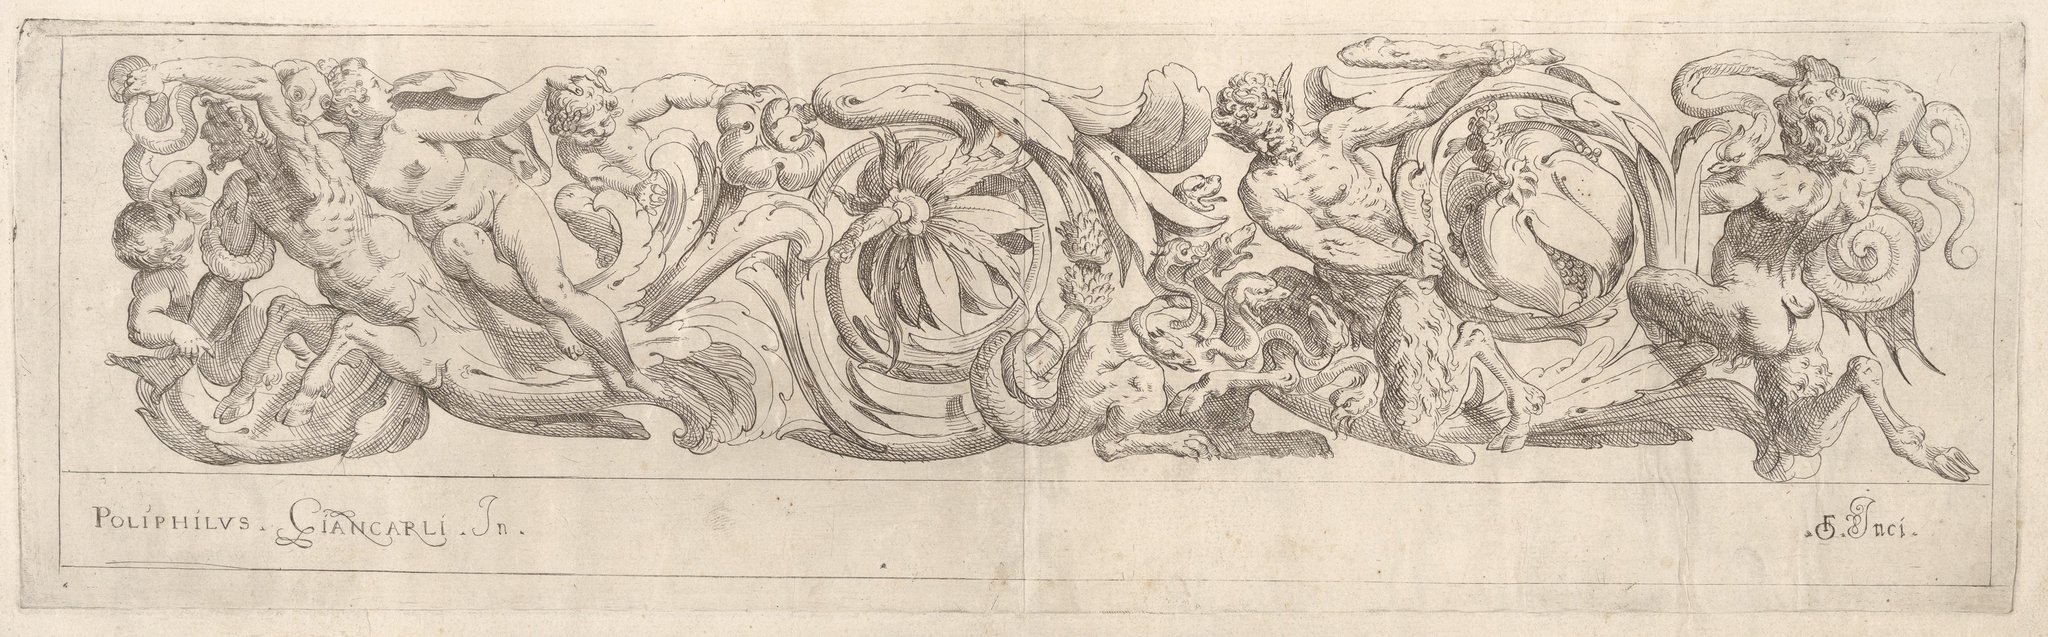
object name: collection ornament architecture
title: Disegni Varij di Polifilo Zancarli (Friezes)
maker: polifilo giancarli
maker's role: artist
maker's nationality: italian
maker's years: 1600-1625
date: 1625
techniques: etching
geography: italy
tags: female nudes,centaurs,dragons,satyrs,snakes